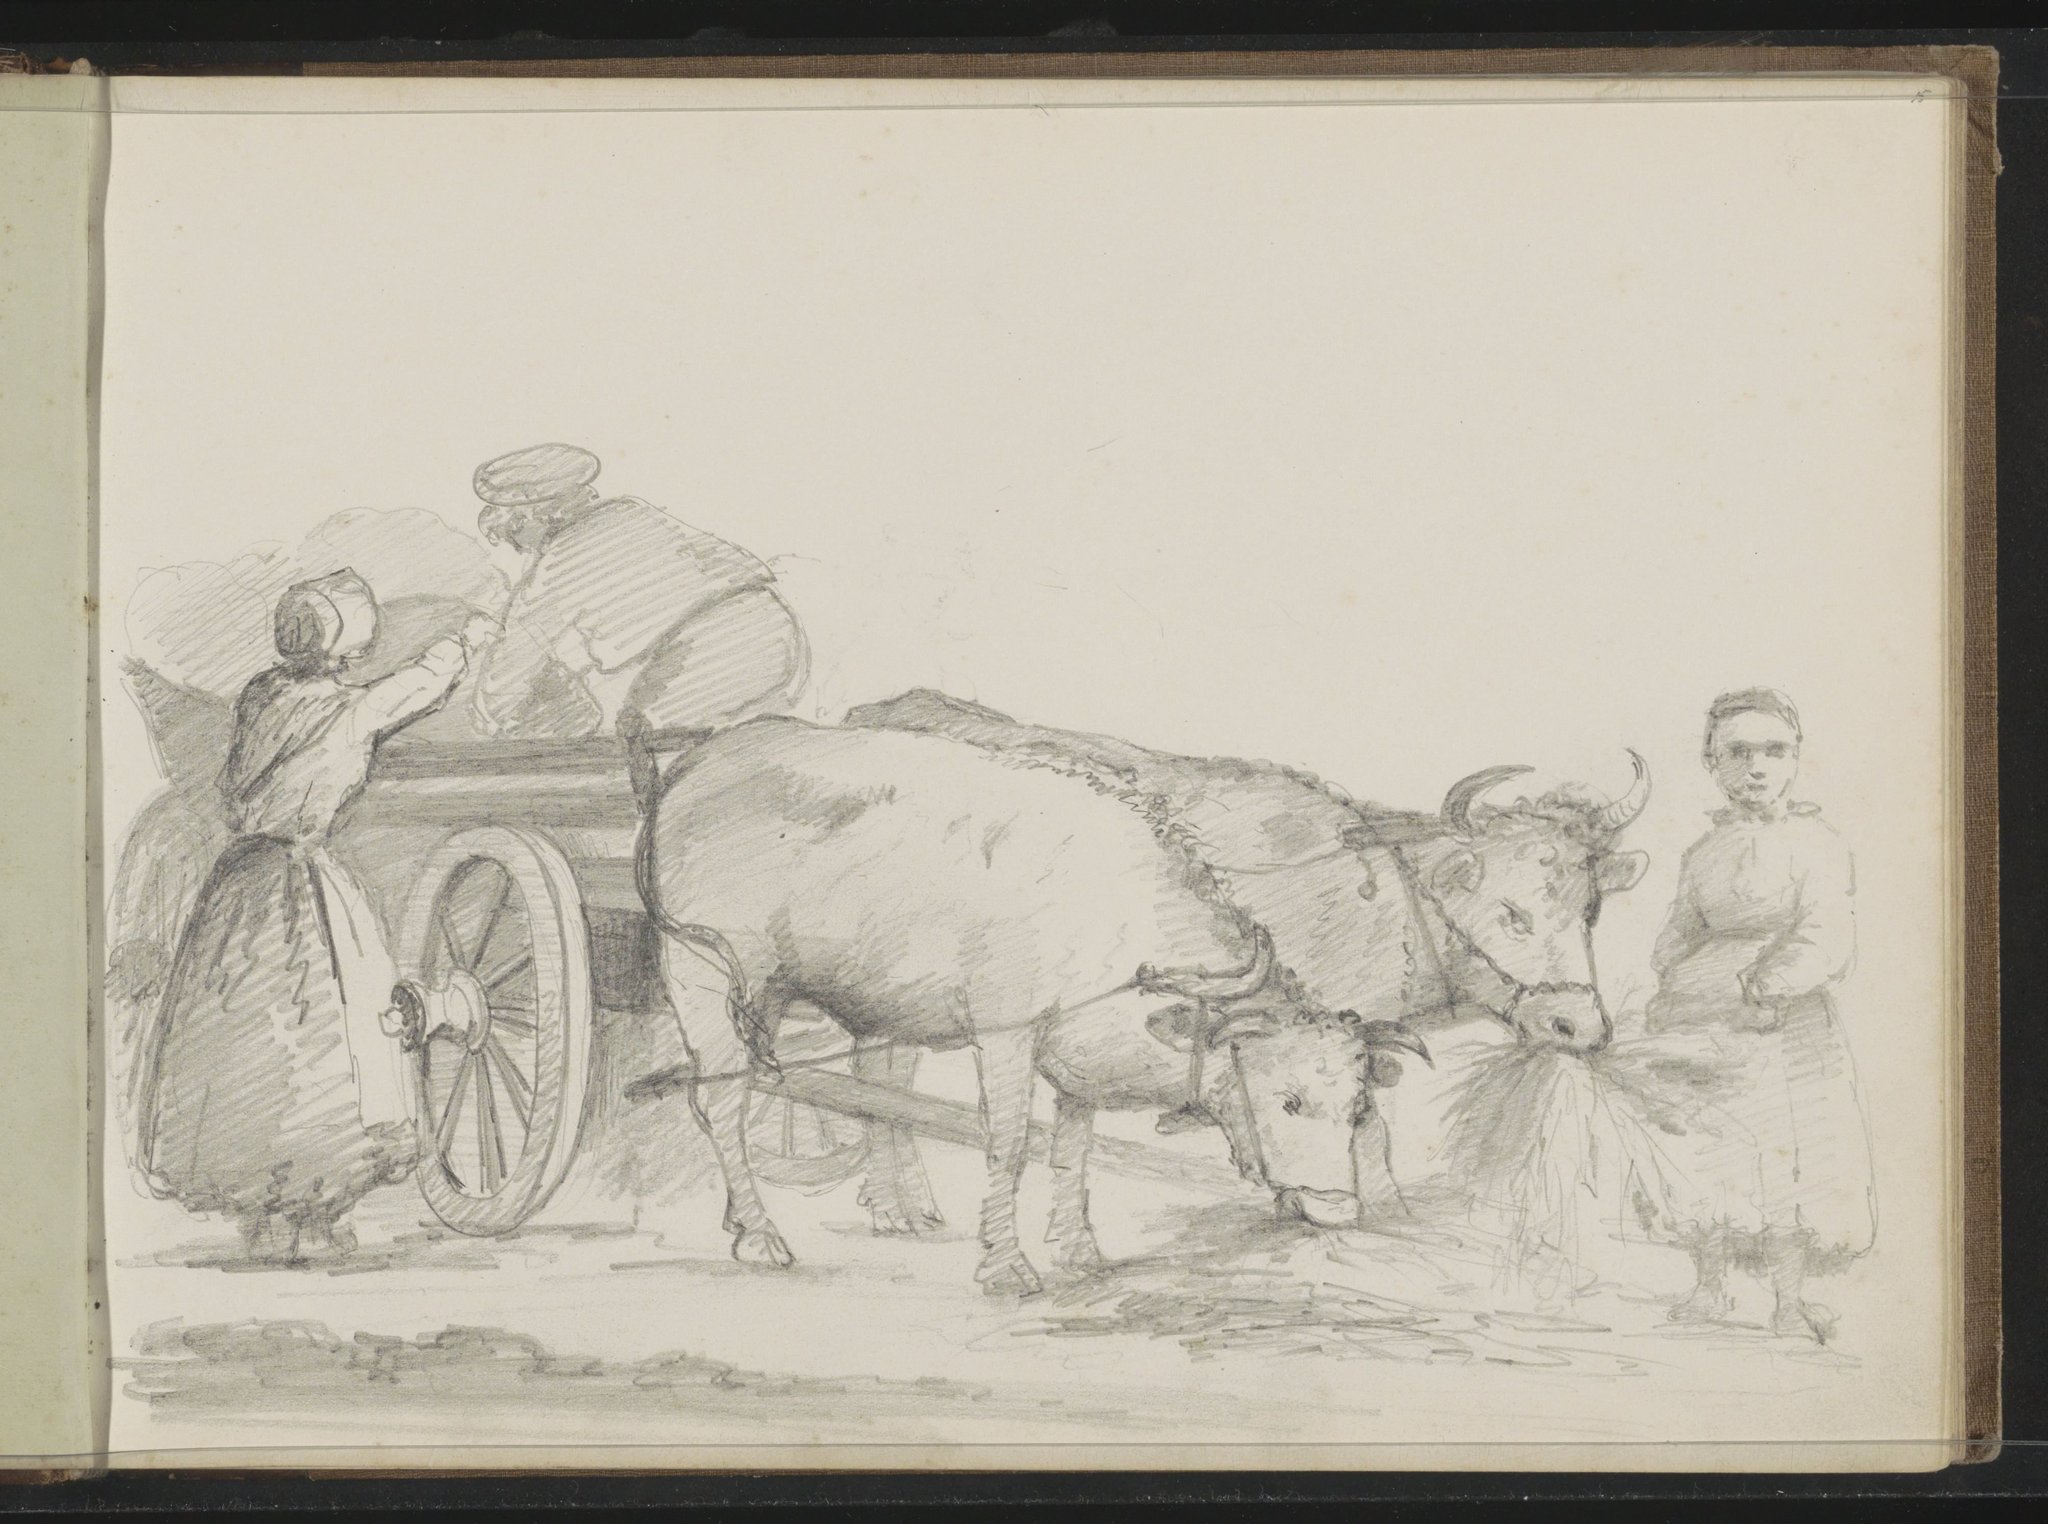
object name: sketchbook leaf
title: Drie figuren bij een ossenkar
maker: hendrik valkenburg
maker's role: draughtsman, painter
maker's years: 1826-1896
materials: paper, pencil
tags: farmers, ox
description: Een meisje voert de twee ossen terwijl een man en vrouw iets in of uit de kar laden. Blad 15 recto uit een schetsboek met 77 bladen.